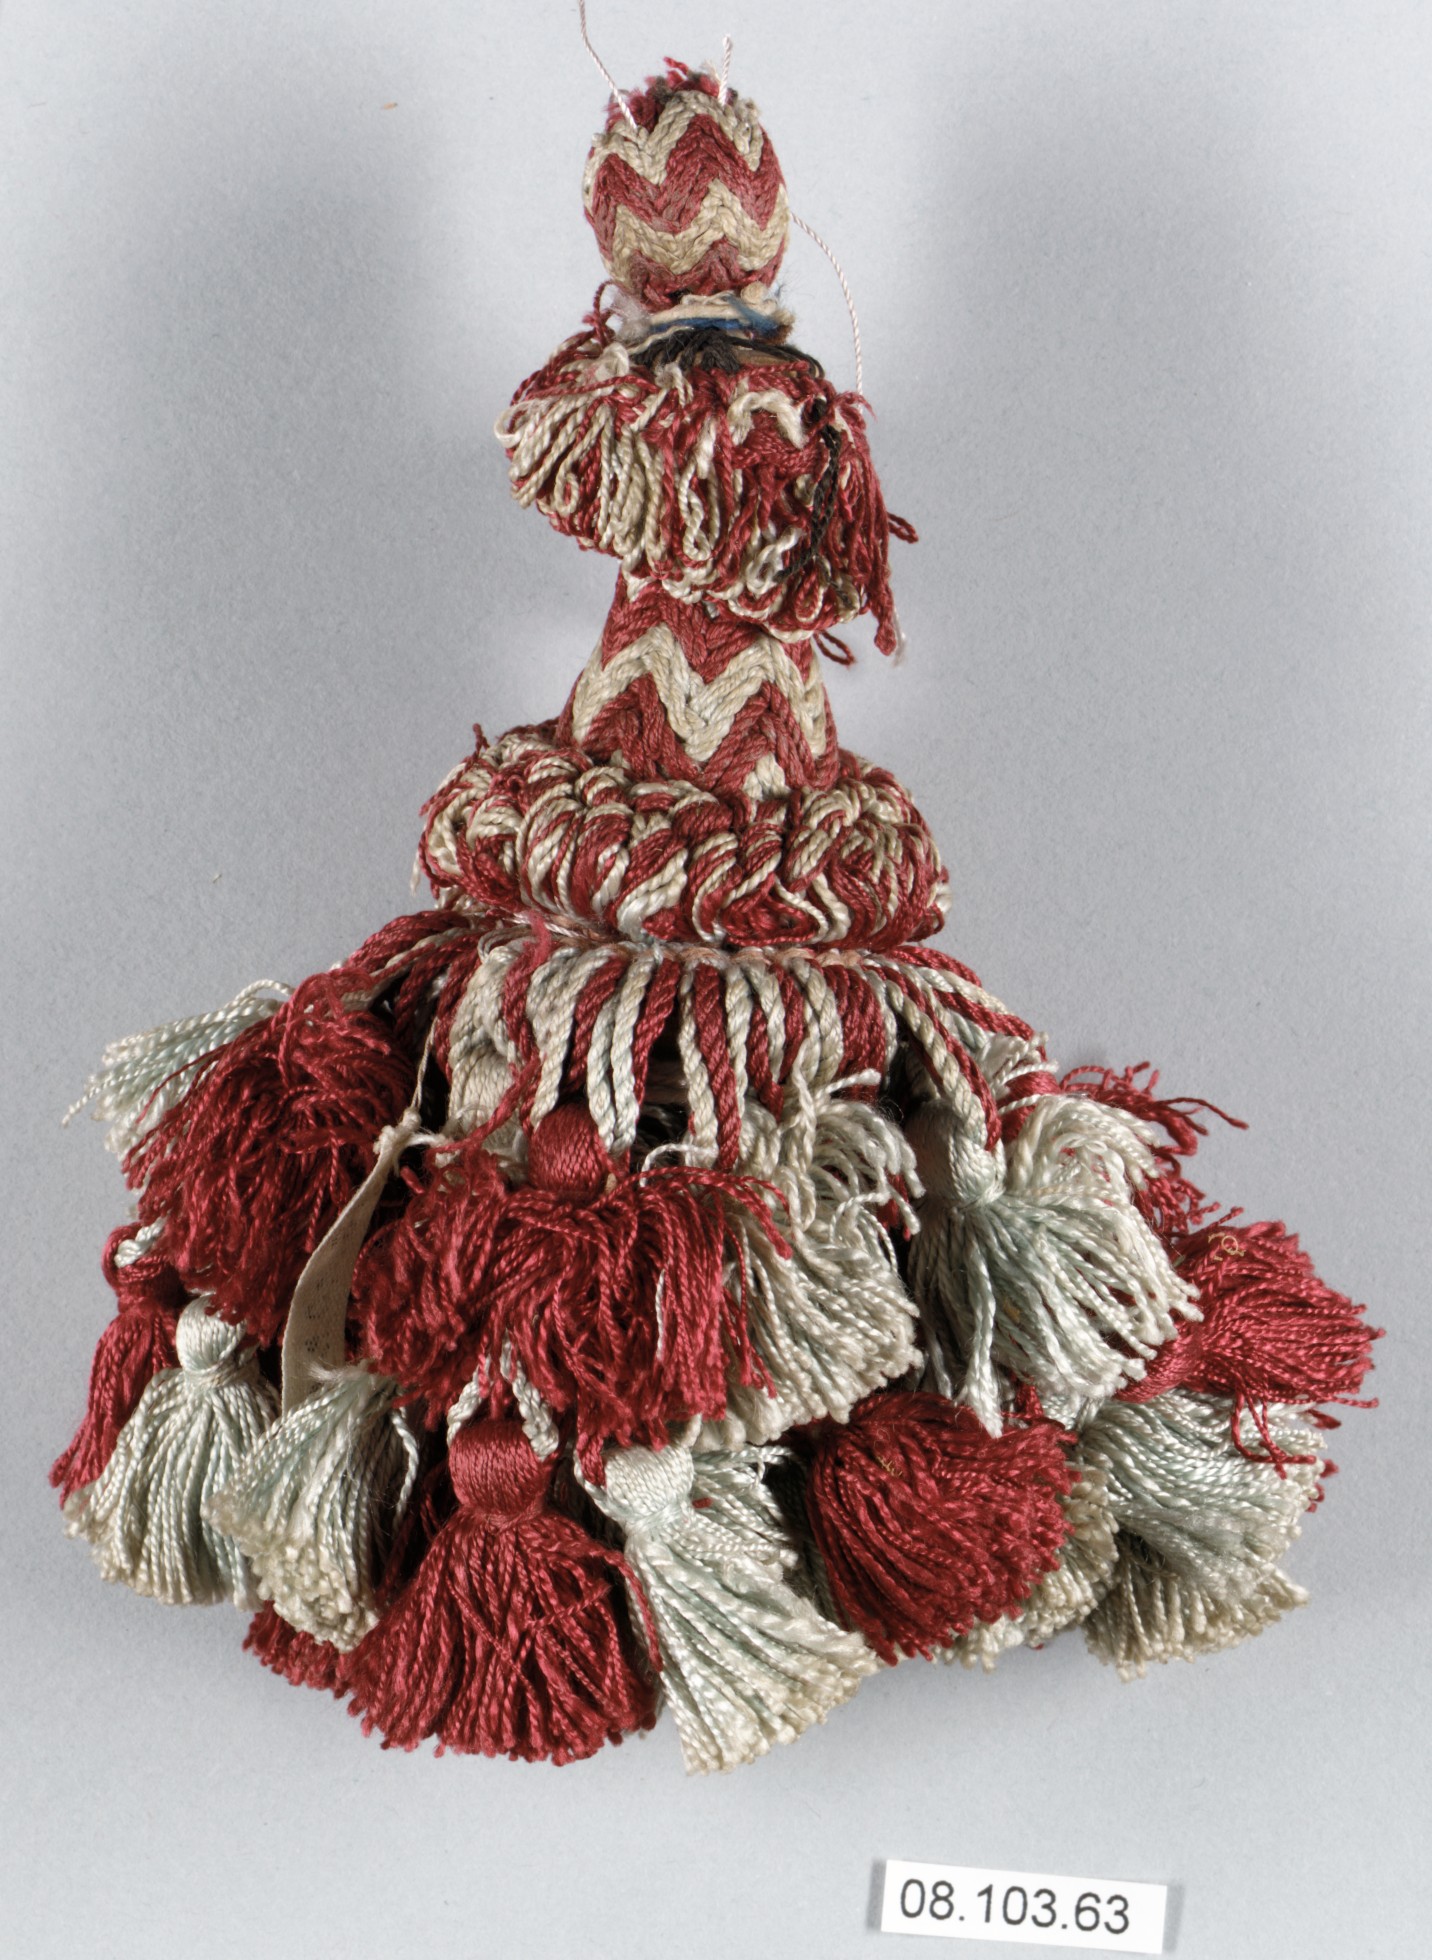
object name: tassel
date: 1567-1633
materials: silk